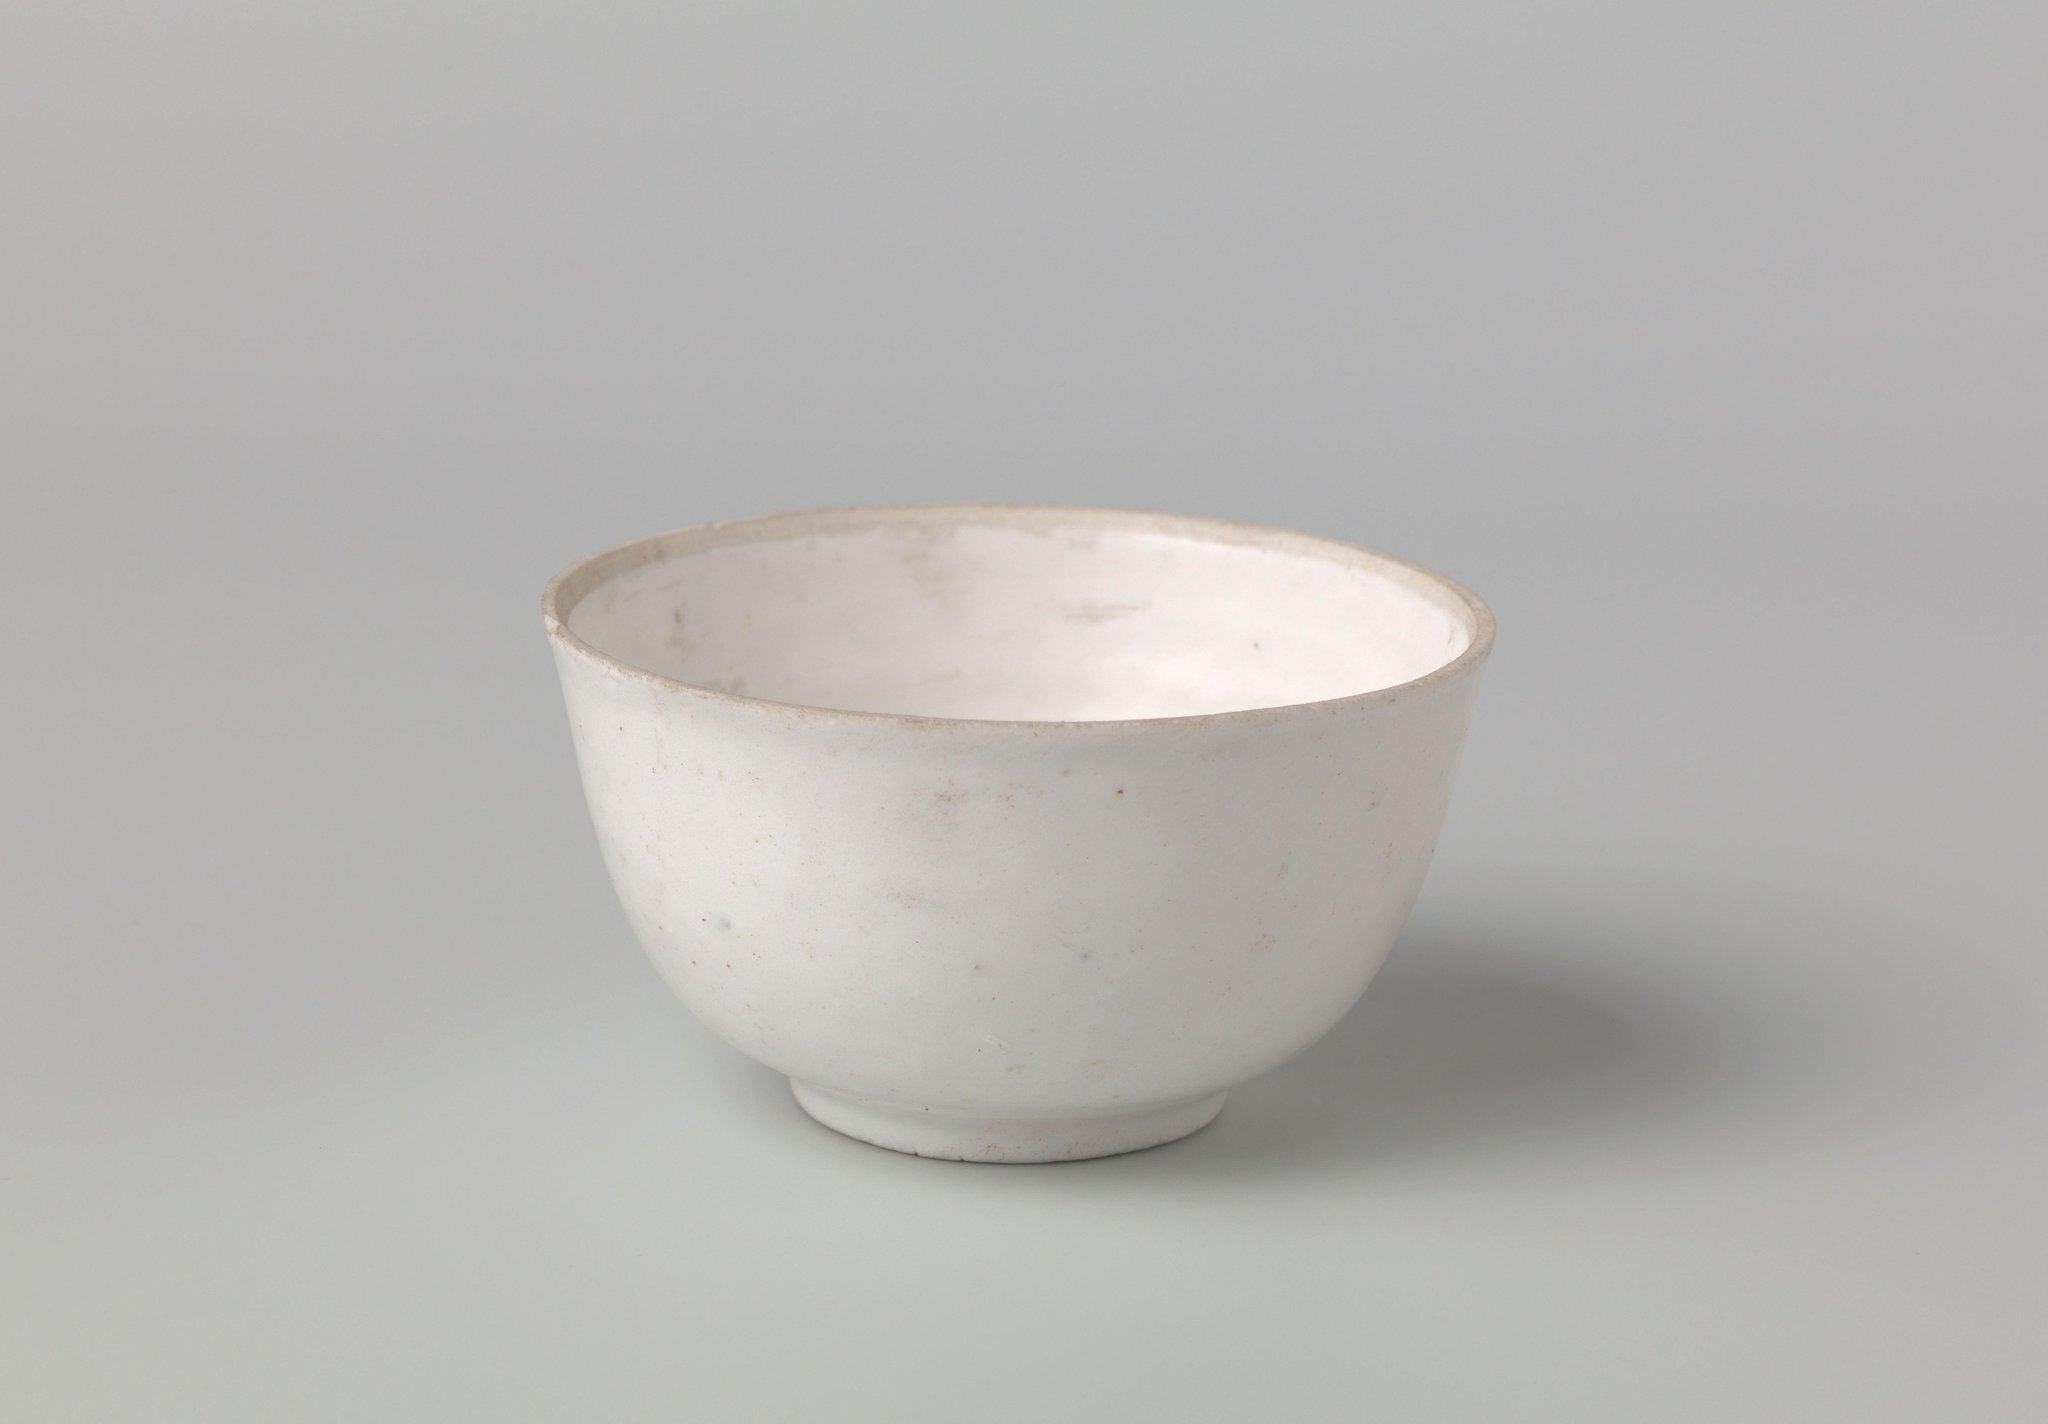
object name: bowl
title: Bowl with a white glaze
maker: Anonymous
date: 1600-1699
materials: glaze, porcelain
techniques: firing, turning, vitrification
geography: south china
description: Klokvormige kom van porselein, bedekt met een wit glazuur. De binnenrand is ongeglazuurd. Wit porselein.